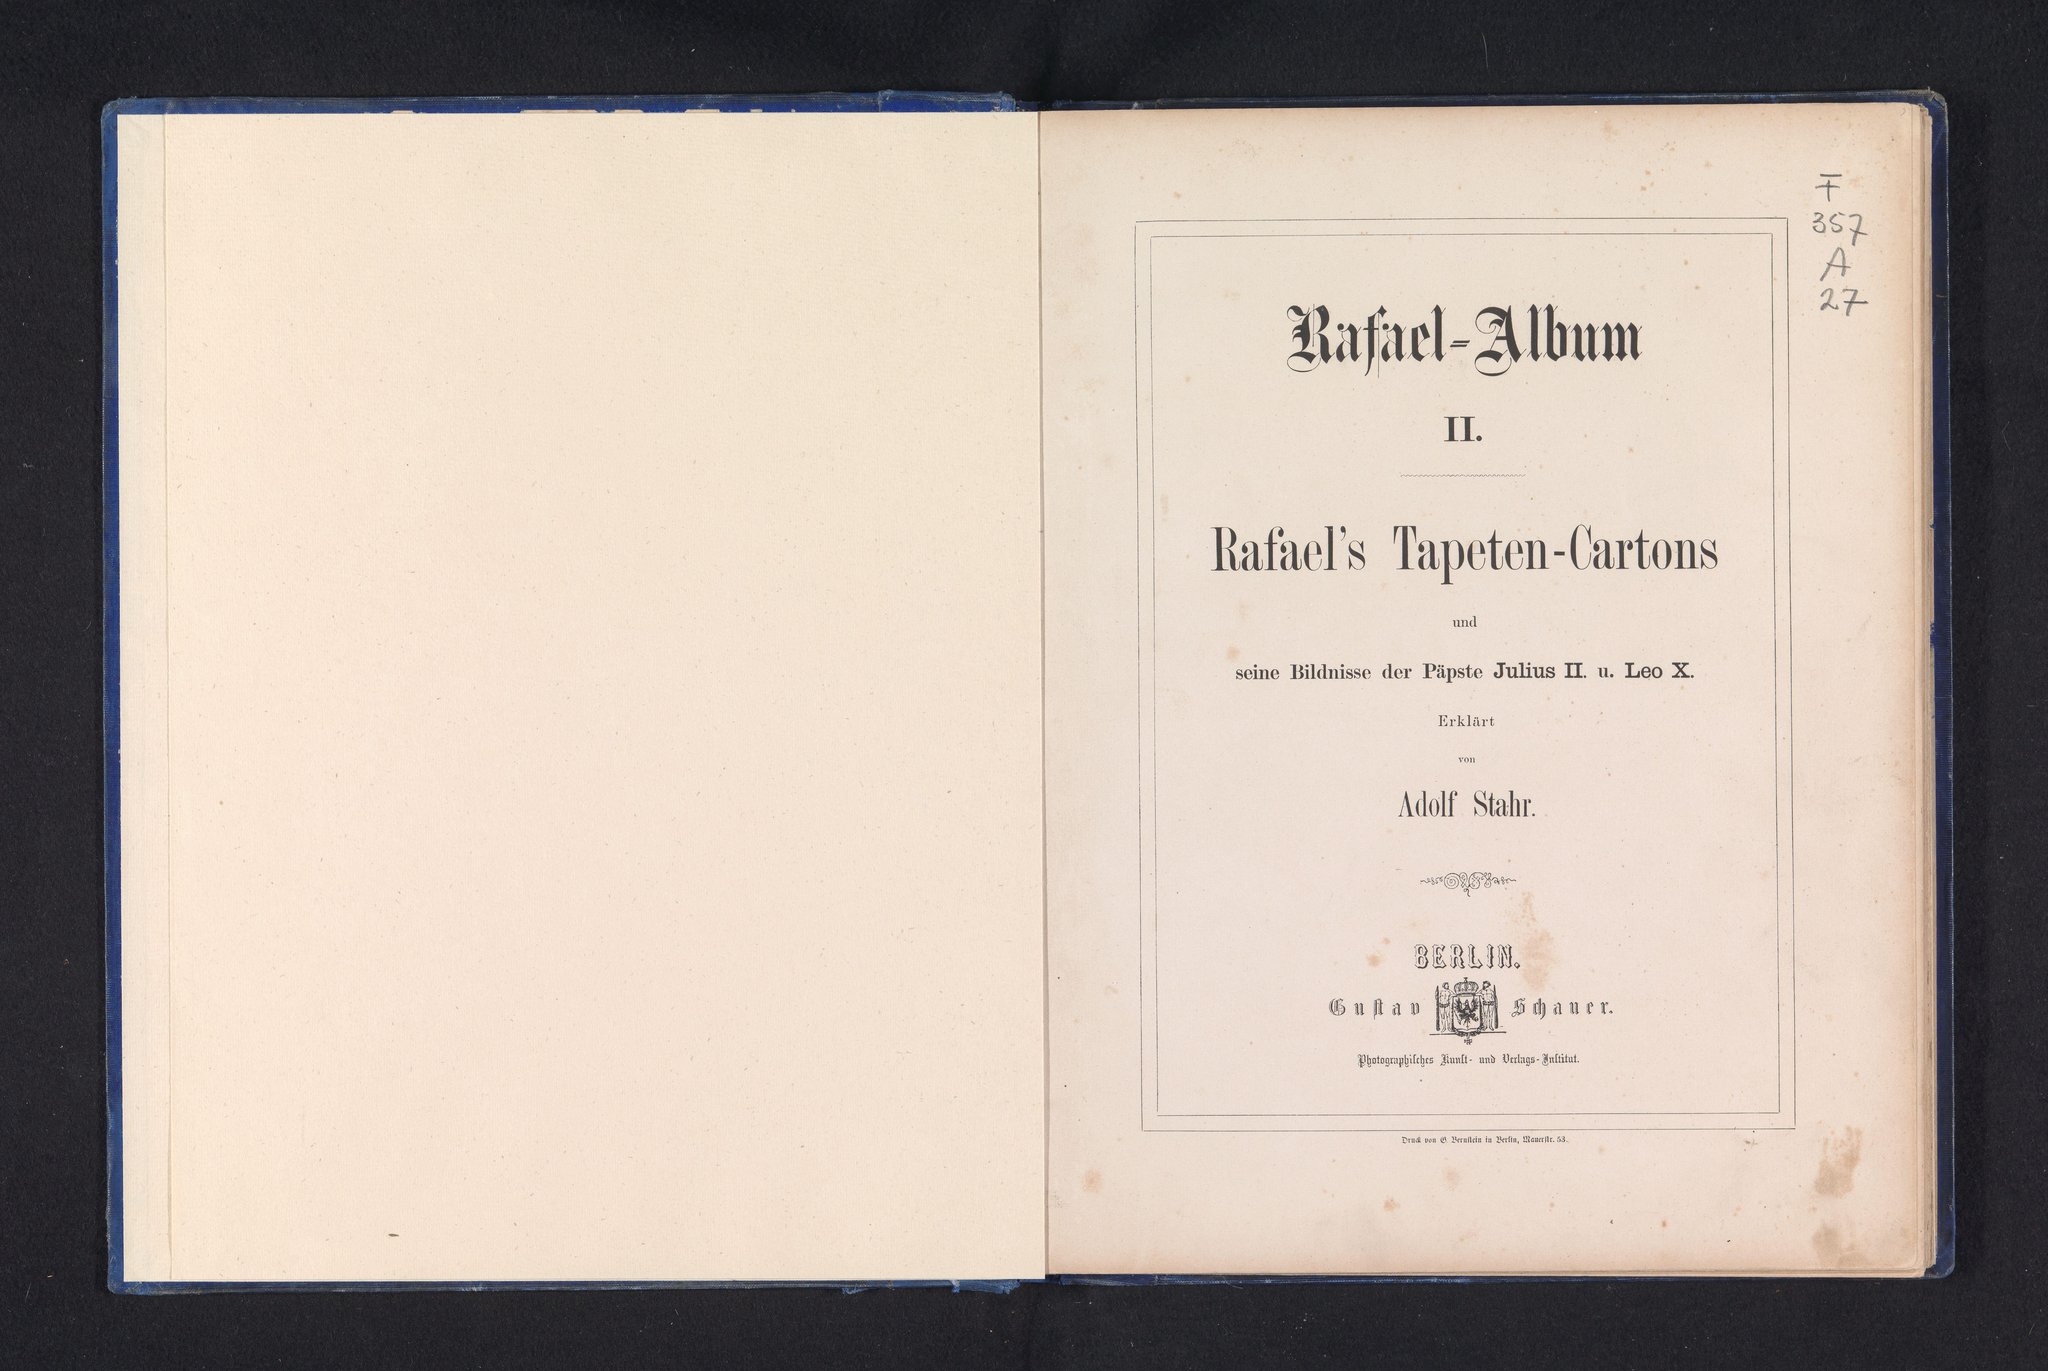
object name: book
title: Rafael-Album II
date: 1861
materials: cardboard, linen, paper, photographic support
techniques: albumen print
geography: berlin